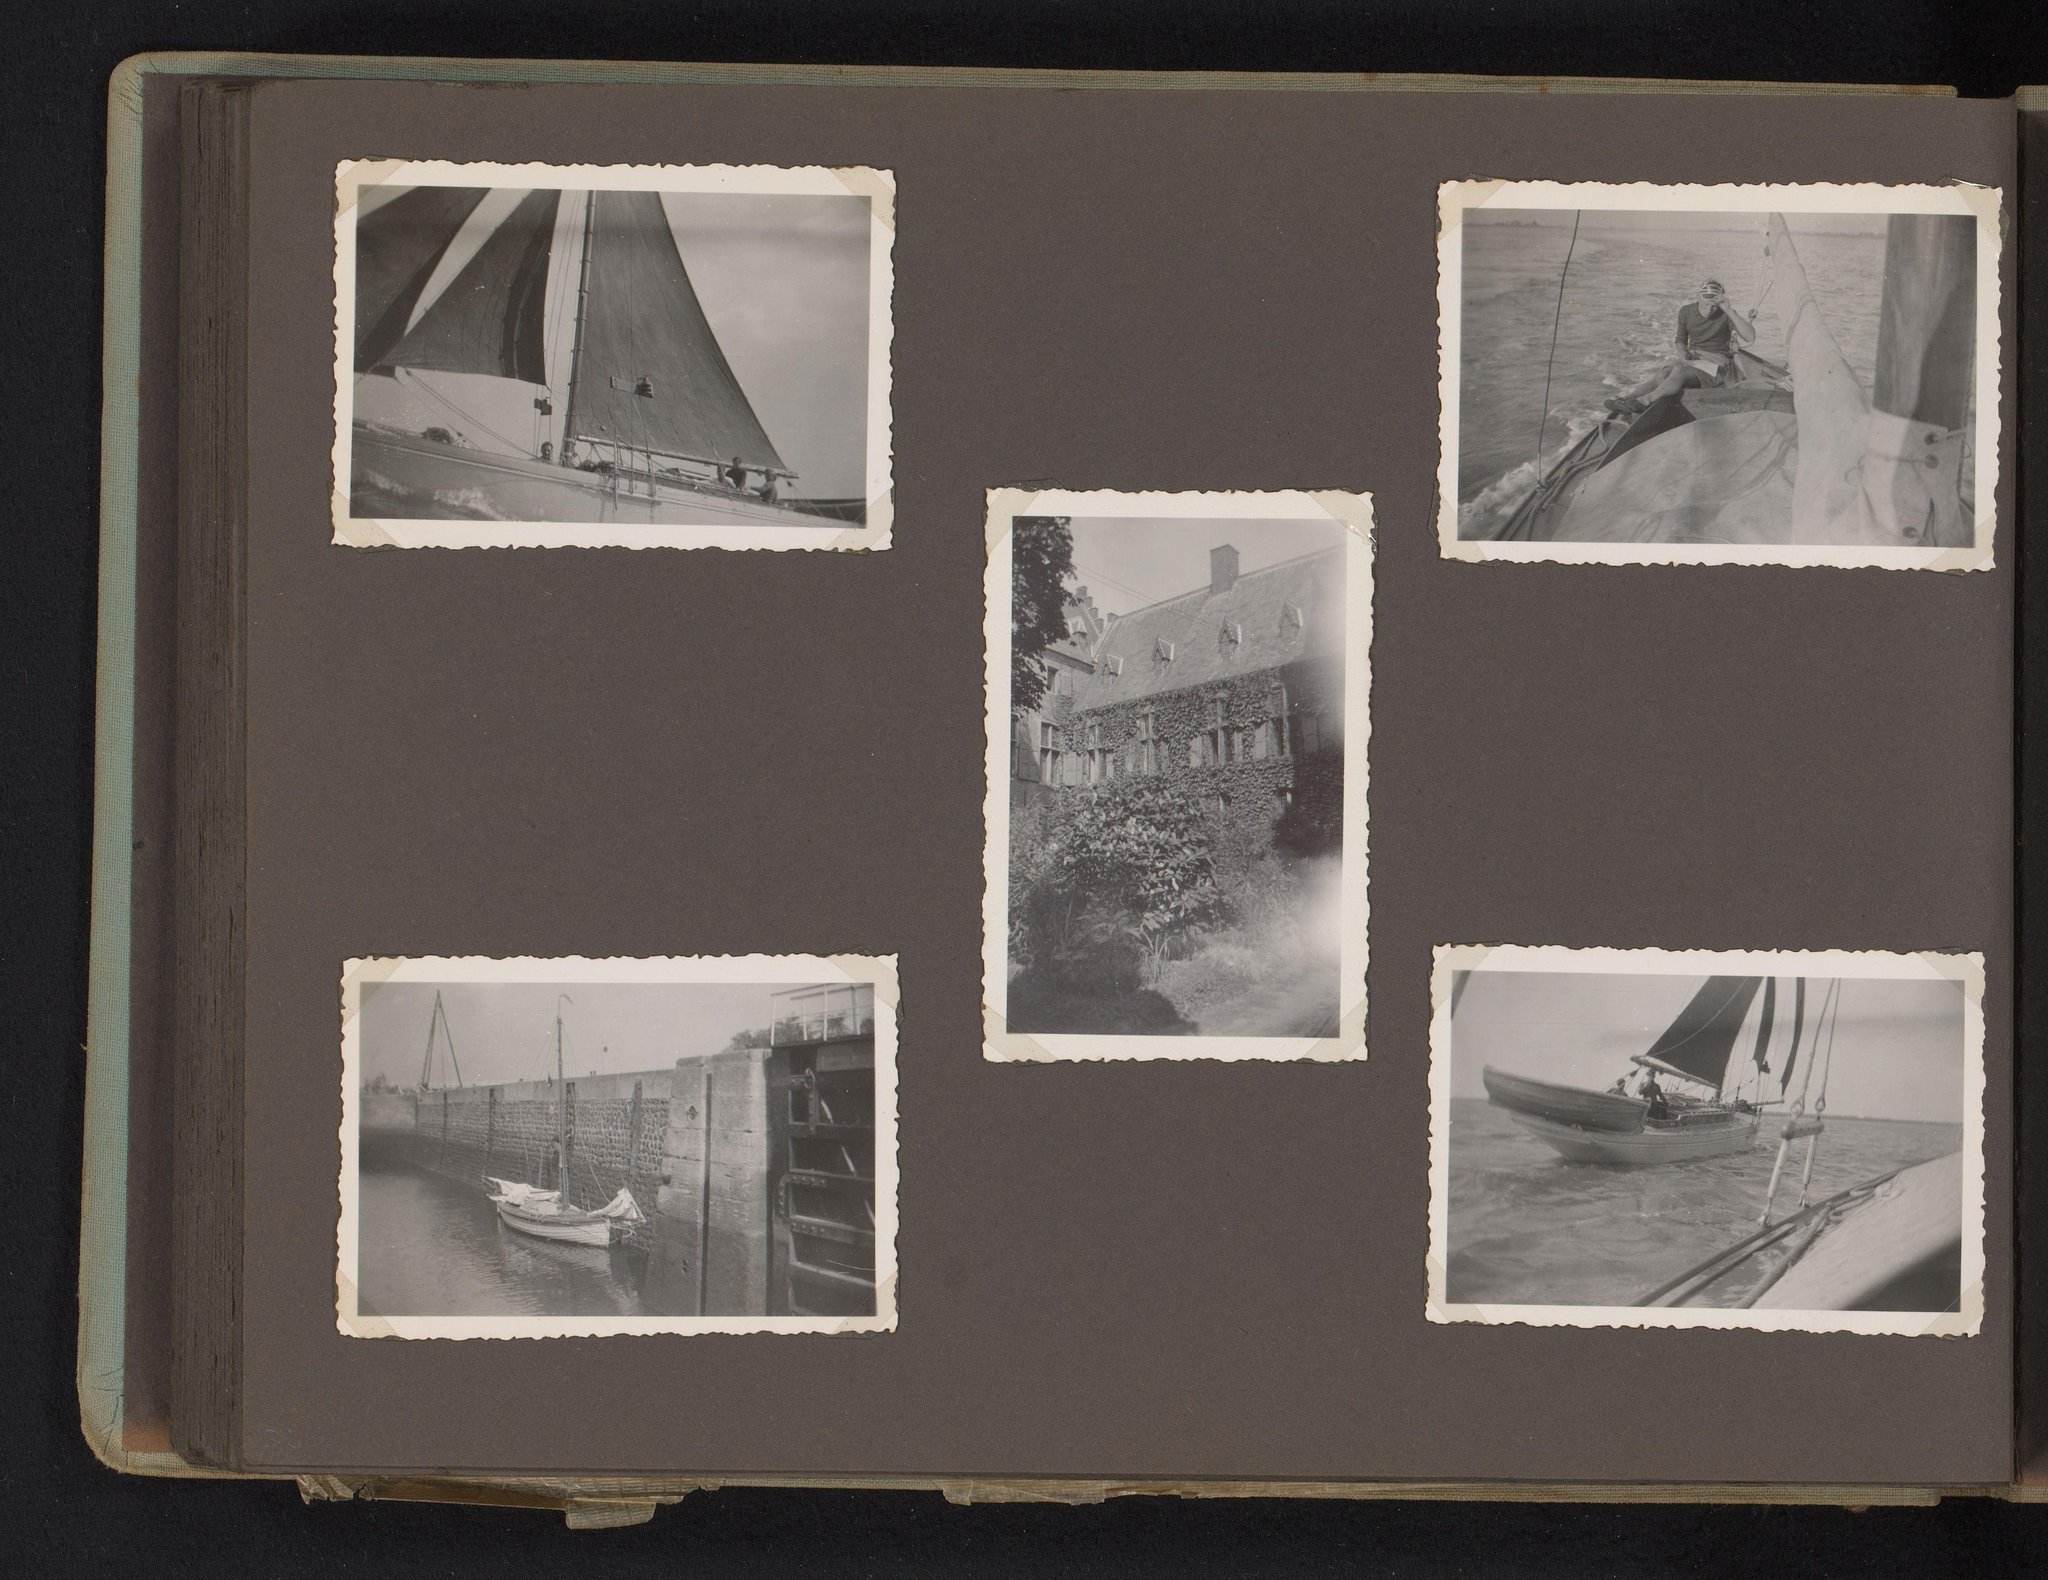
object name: photograph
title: Vakantie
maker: Anonymous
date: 1935-1945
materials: cardboard, photographic support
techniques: gelatin silver print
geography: netherlands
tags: sailing-ship, sailing-boat, outing, pleasure trip, netherlands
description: Albumblad met vijf foto's van een vakantie op een zeilboot. Onderdeel van het fotoalbum van een jonge vrouw, ca. 1935-1945.